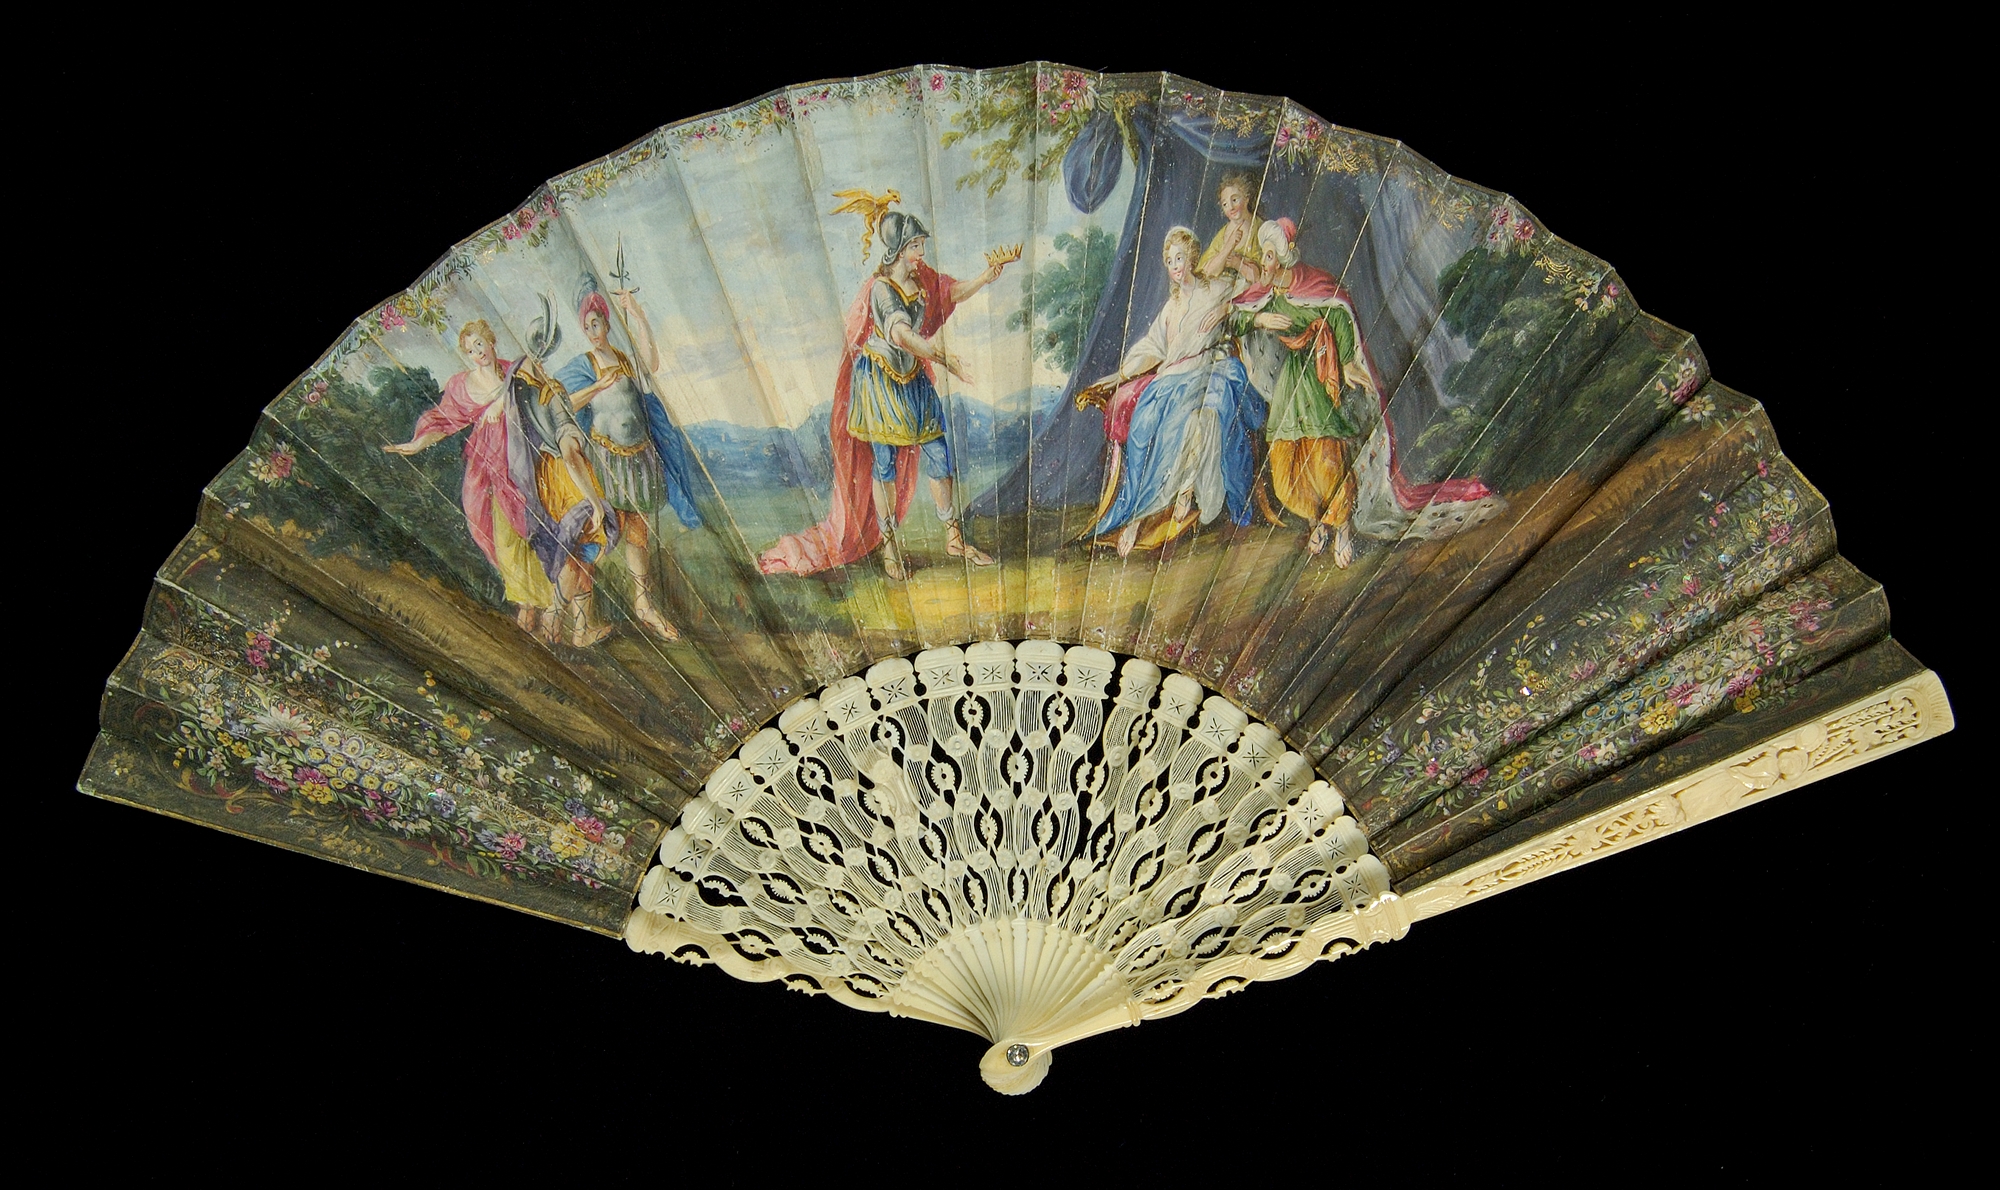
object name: fan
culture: british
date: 1780-1799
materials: ivory, paper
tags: men,women,flowers